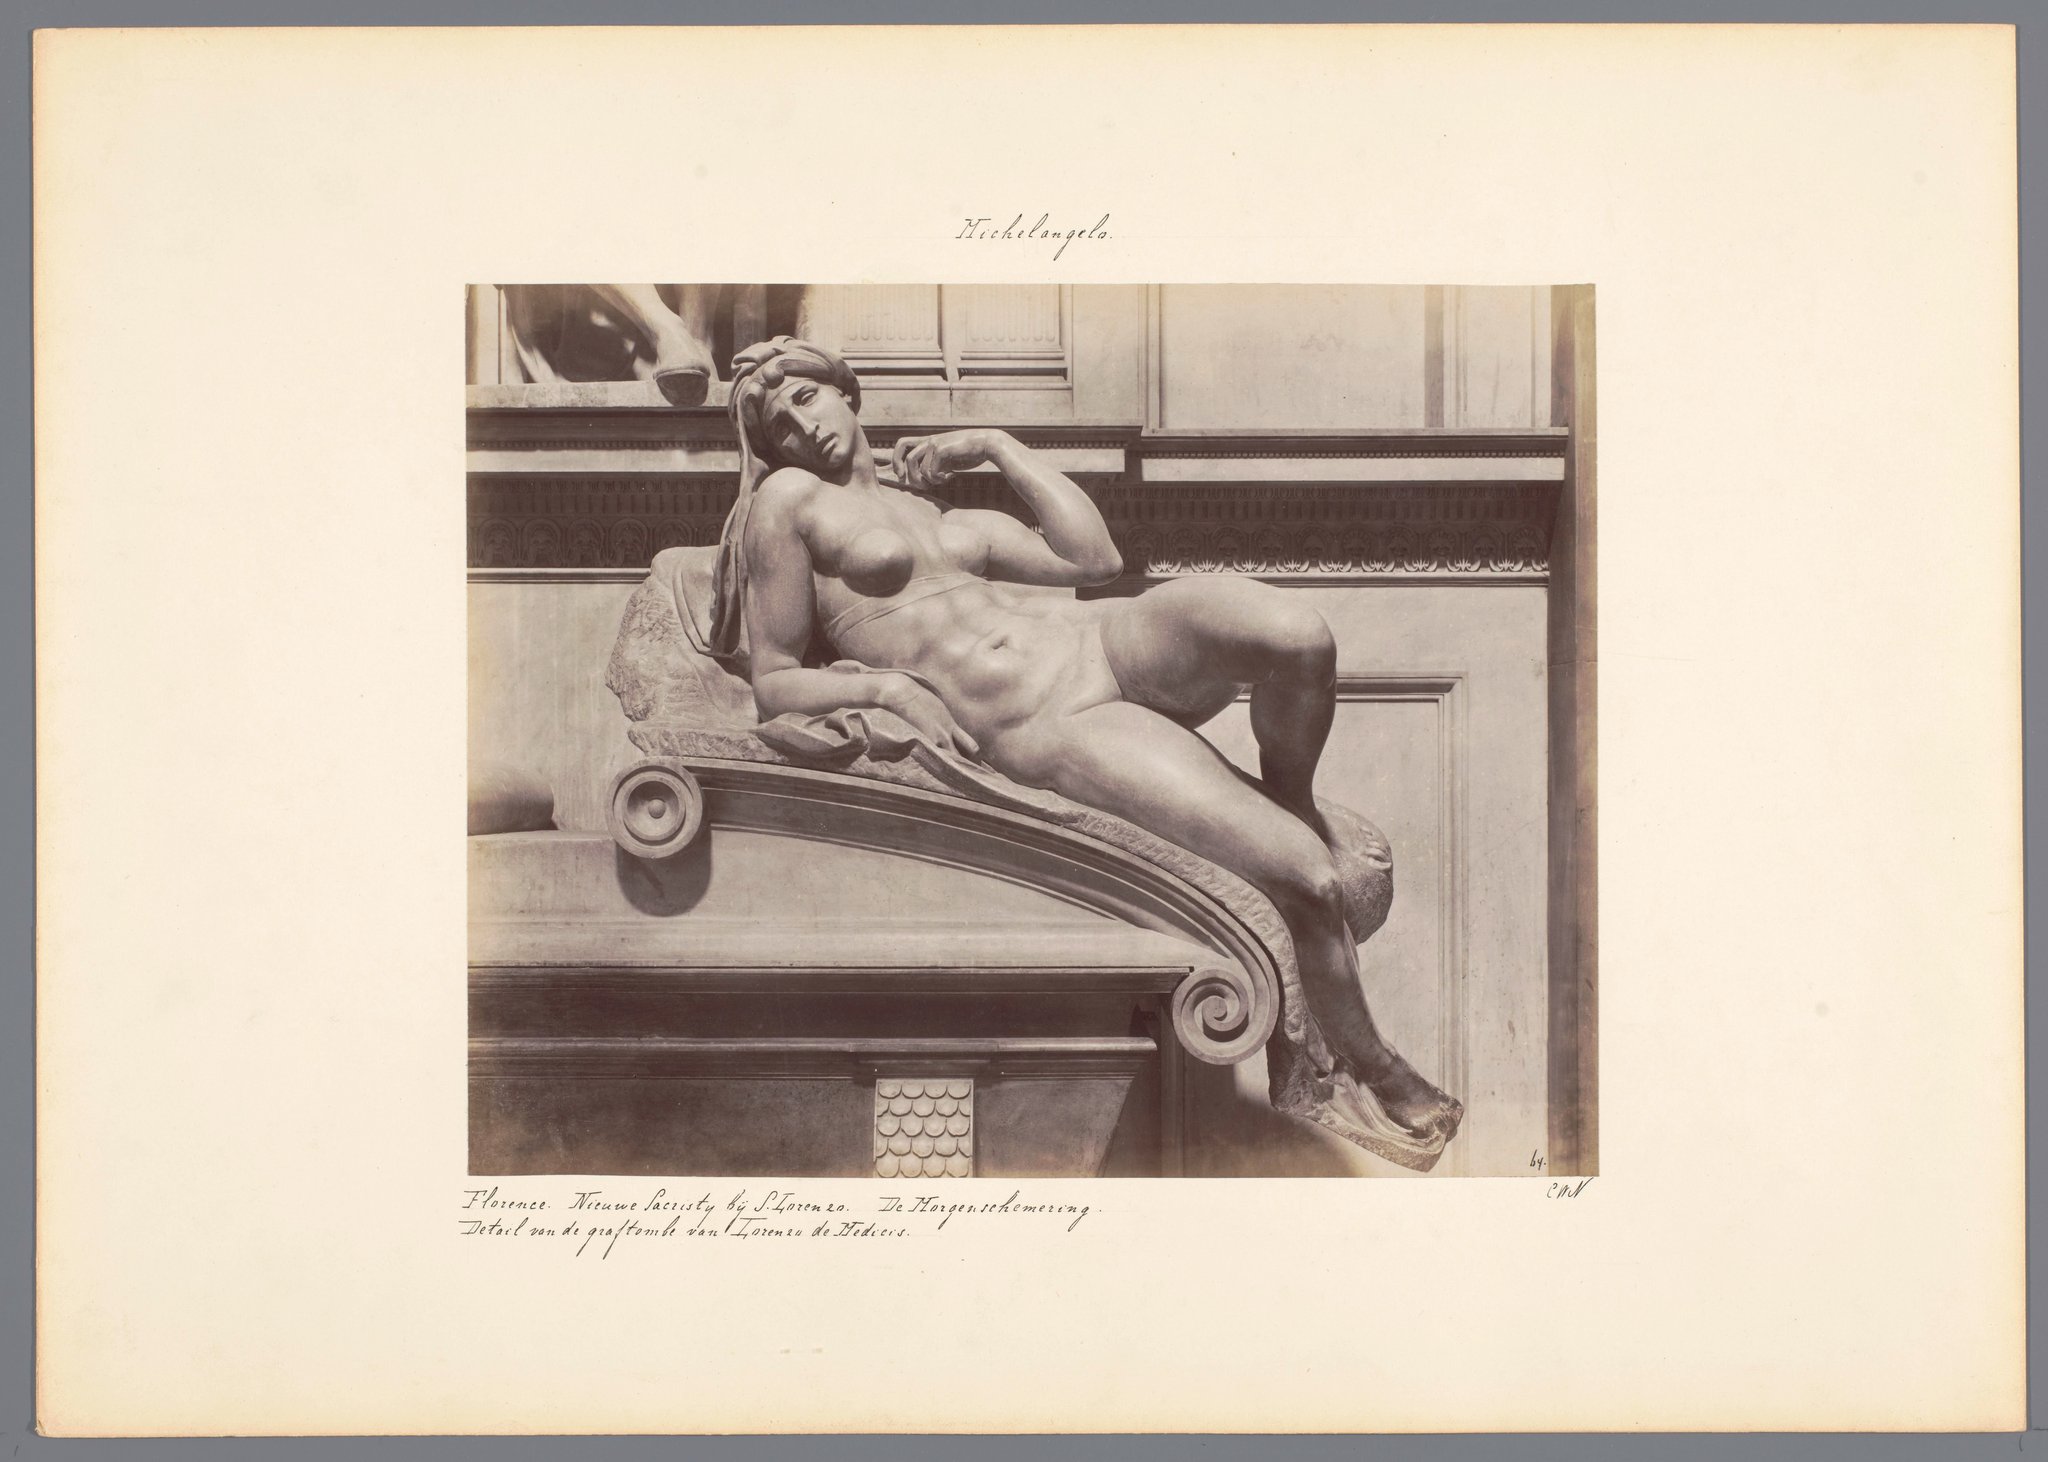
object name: photograph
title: Personificatie van de morgenschemering op de graftombe van Lorenzo de' Medici gemaakt Michelangelo in de Cappelle Medicee te Florence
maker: Anonymous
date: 1875-1900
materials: cardboard, photographic support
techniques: albumen print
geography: florence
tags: grave, tomb, monument, statue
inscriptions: inscription: ‘CWN.’, collector's mark: ‘KUNSTNIJVERHEIDSCHOOL QUELLINUS AMSTERDAM FRANS HALSSTRAAT 14.’, number: ‘64.’, collector's mark: ‘INSTITUUT VOOR KUNST-NIJVERHEIDSONDERWIJS GABRIËL METSUSTRAAT No. 16 AMSTERDAM’